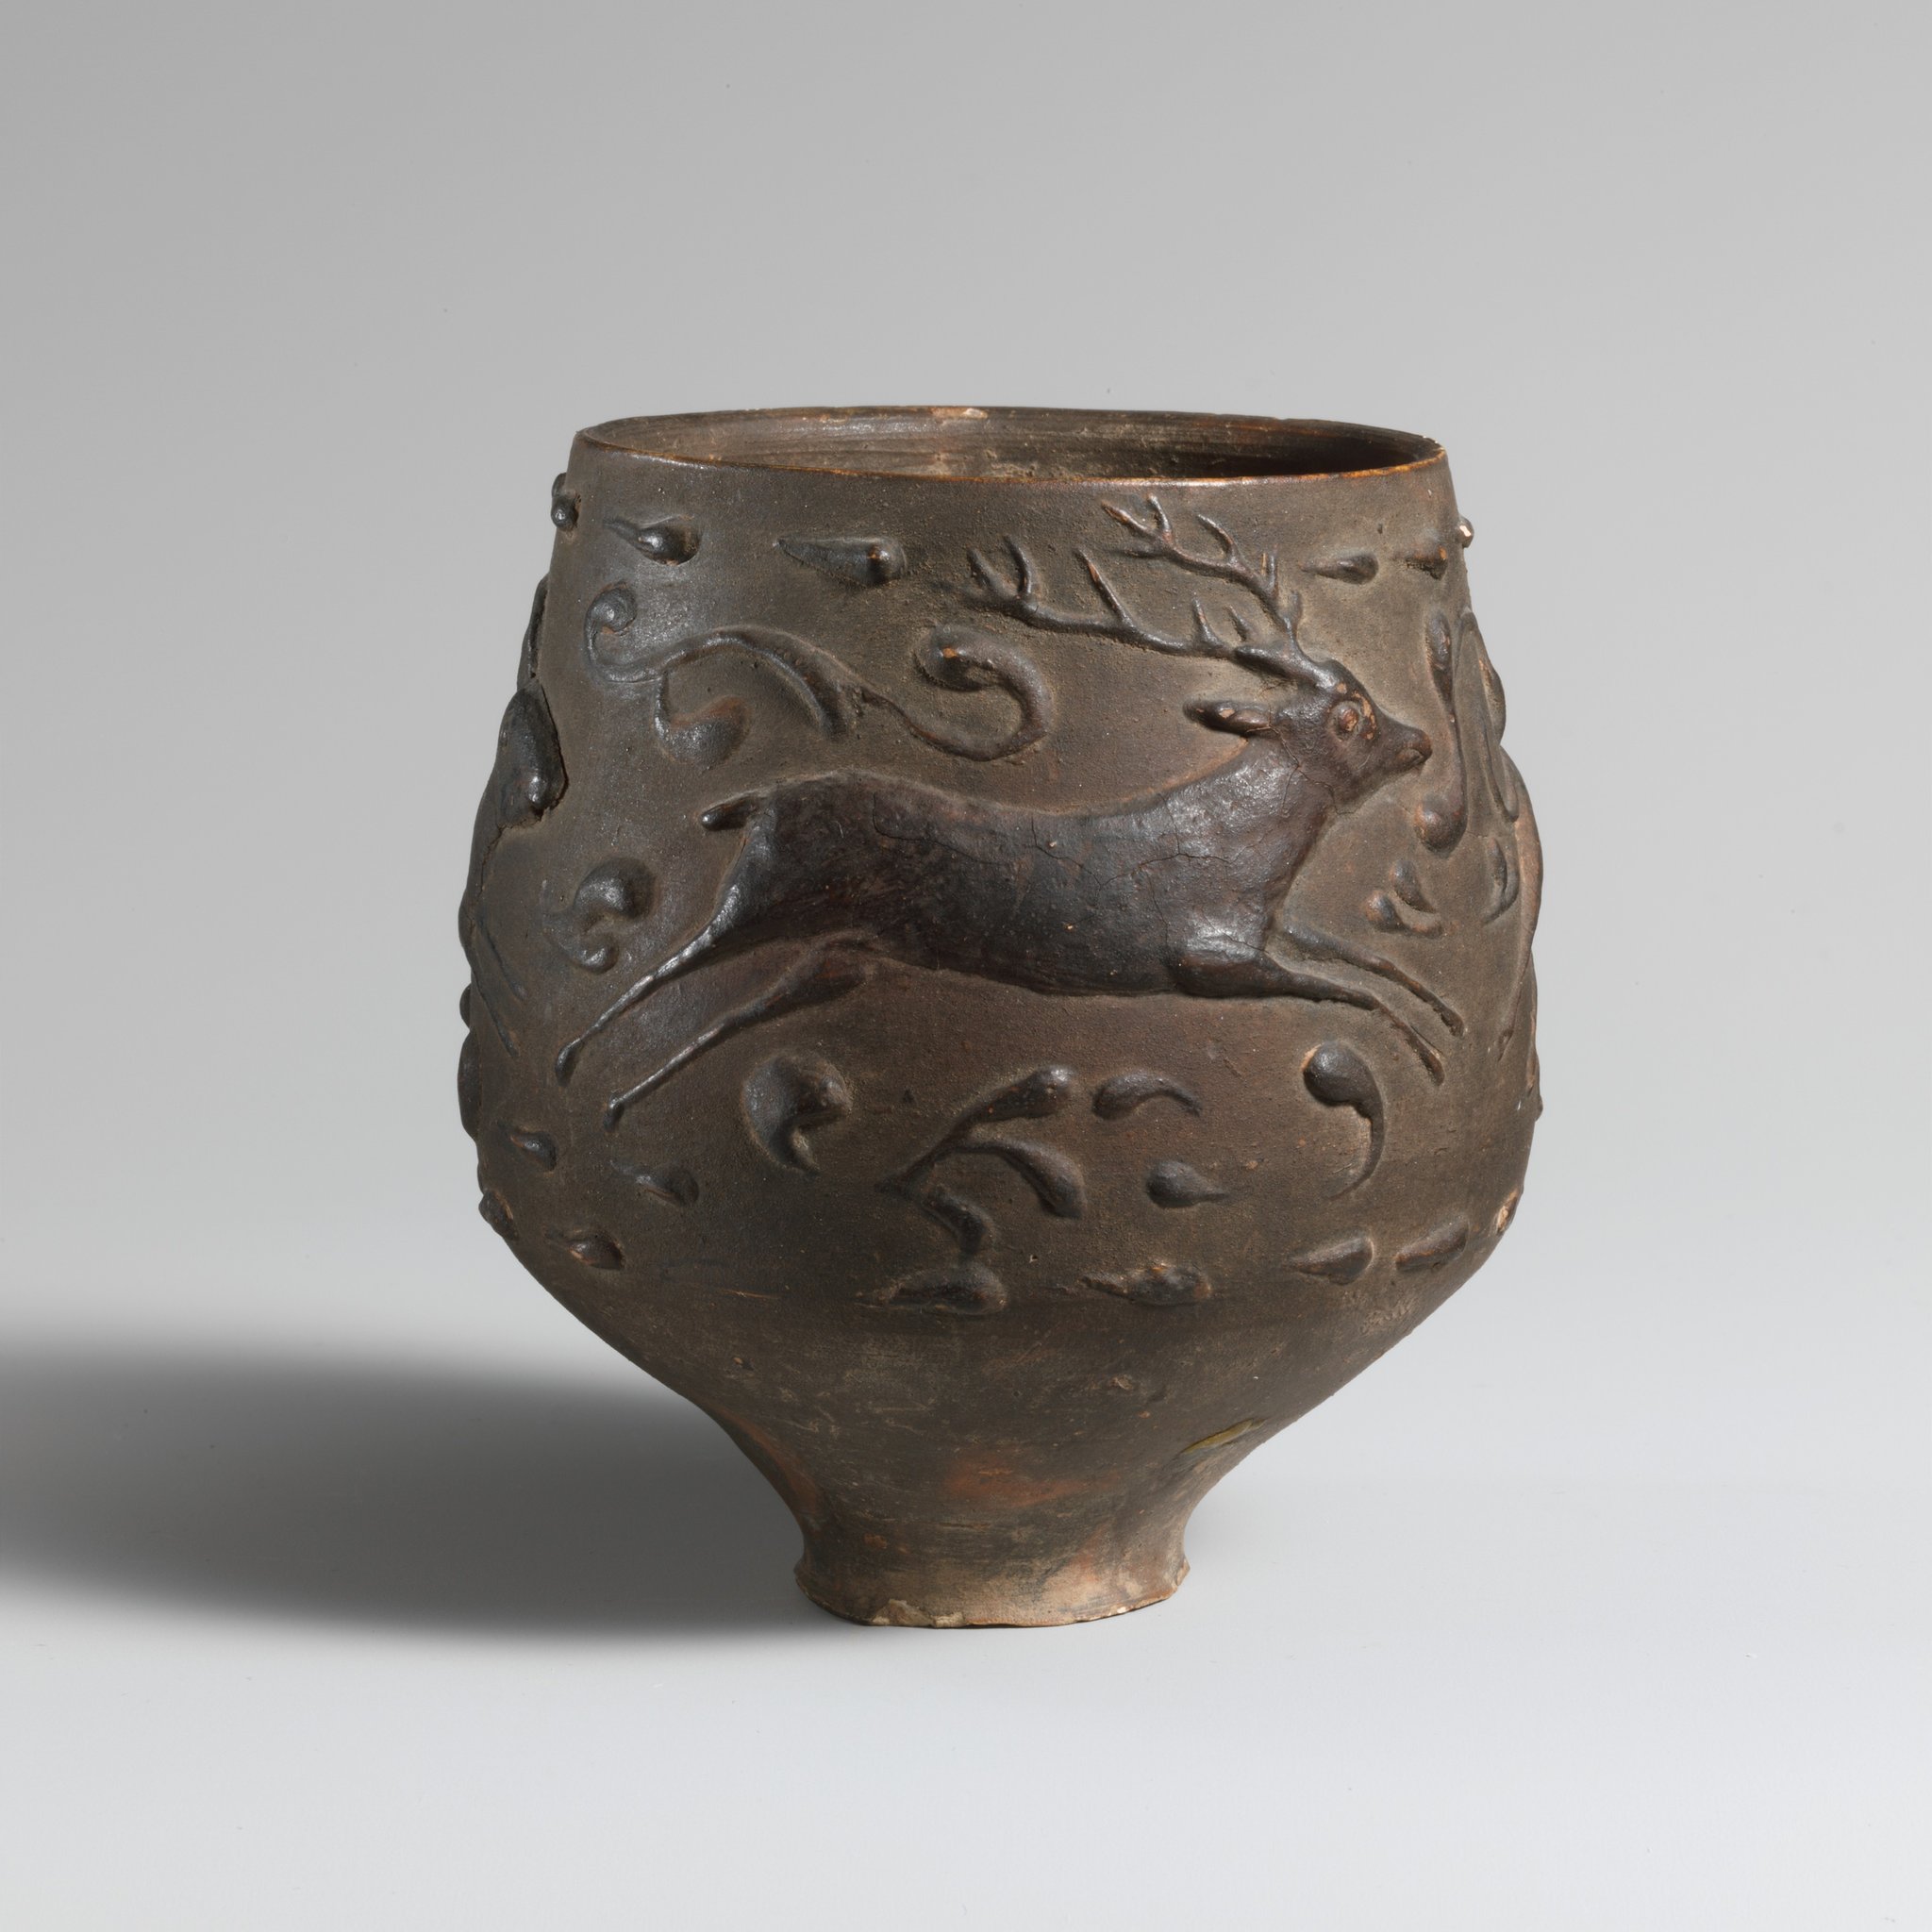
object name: cup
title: Terracotta cup with barbotine decoration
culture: roman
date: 101-233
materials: terracotta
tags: deer